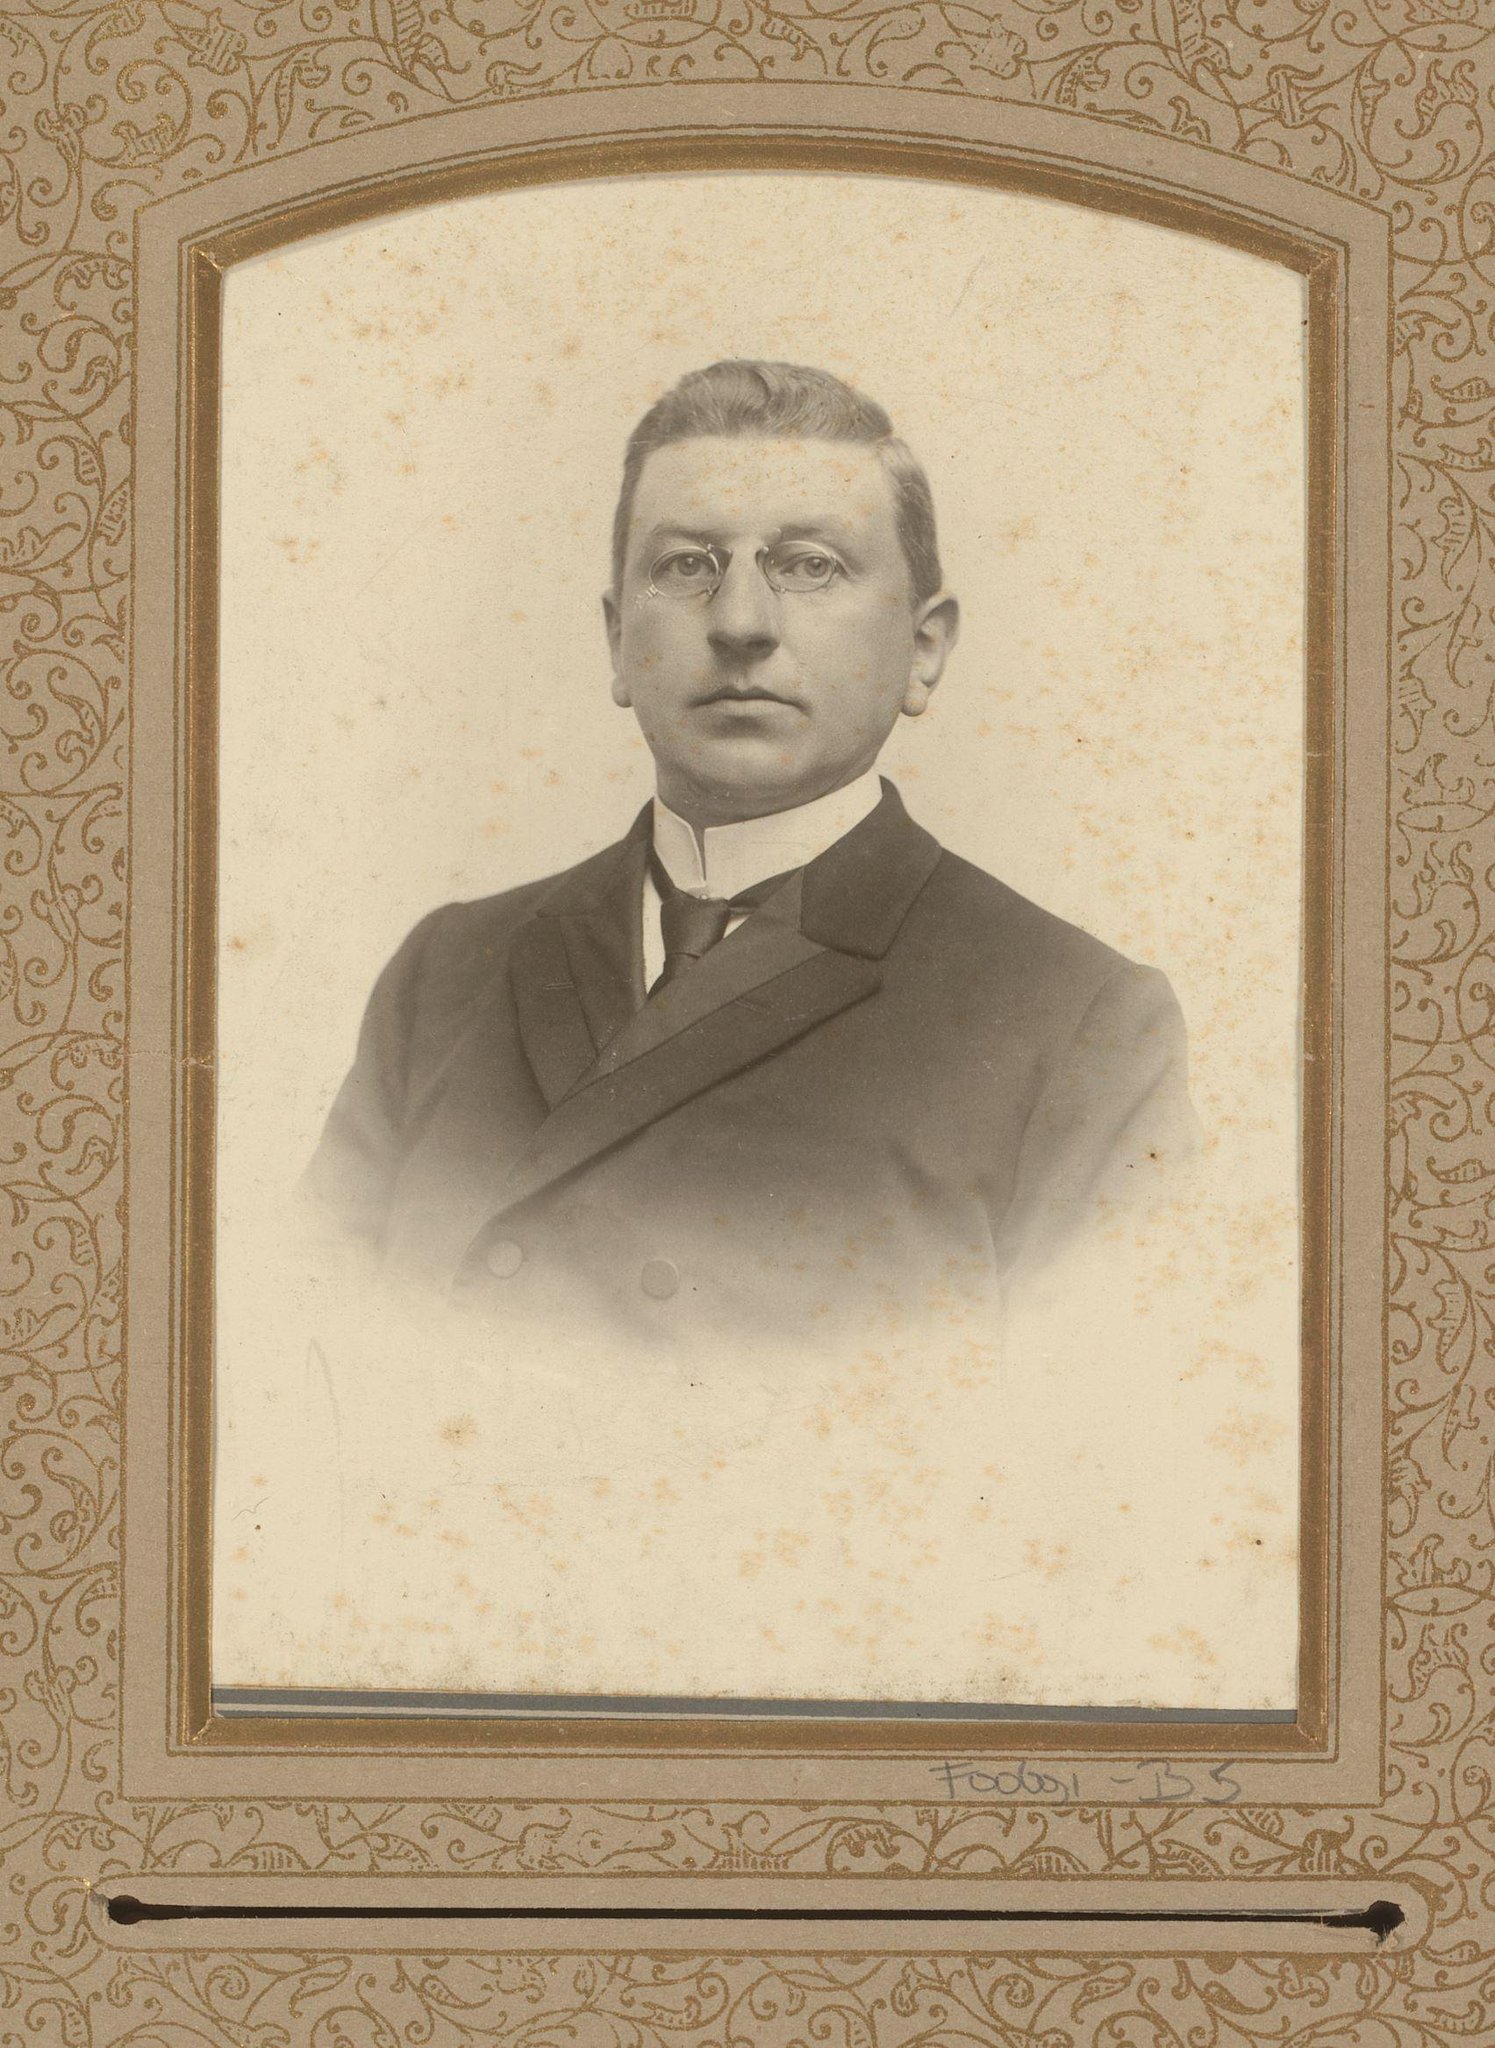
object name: album leaf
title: Portret van een man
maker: thomas johannes bouwmeester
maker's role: fotograaf, retoucheur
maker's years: 1861-1942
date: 1897-1908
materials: cardboard, photographic support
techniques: gelatin silver print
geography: leiden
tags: historical persons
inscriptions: inscription: ‘Atelier Bouwmeester/ Hooigracht 86/ Leiden’